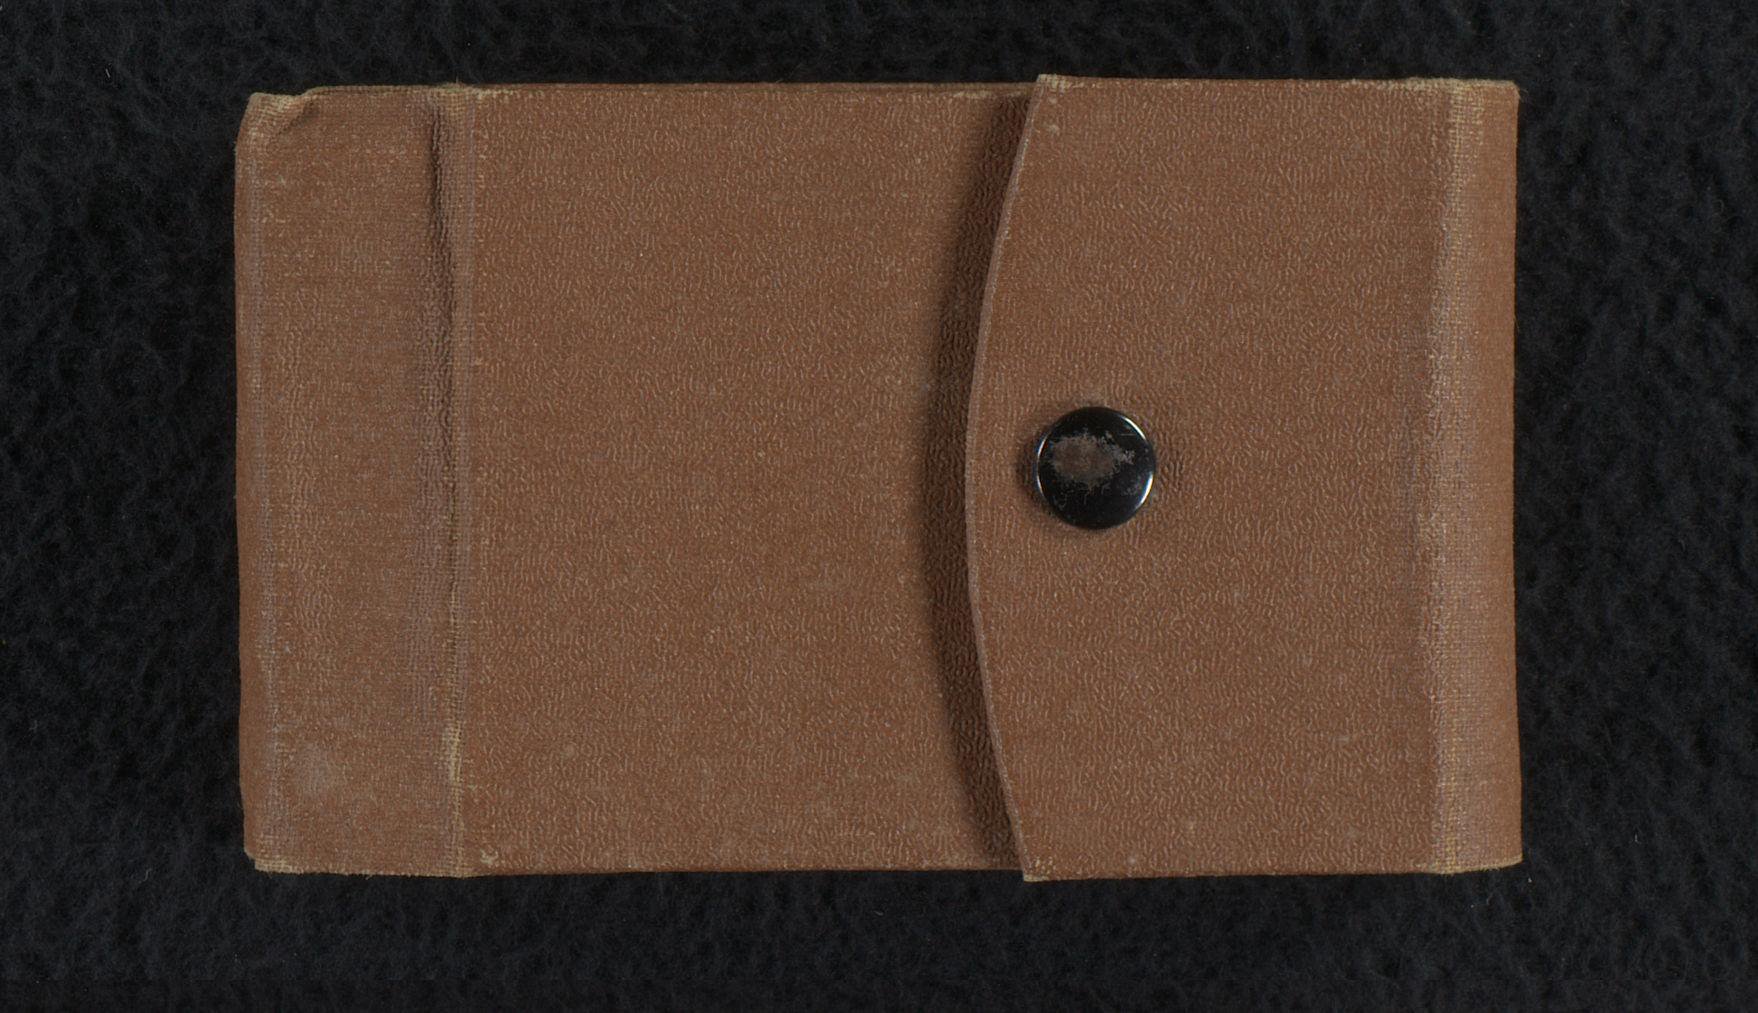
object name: filmnegatief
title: Album met honderd negatieven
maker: Anonymous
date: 1930-1931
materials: paper, cardboard, ink, metal, film, textile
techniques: gelatin silver negative, pen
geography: netherlands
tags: the family travelling, on holiday, historical persons not known by name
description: Negatiefalbum met honderd negatieven van een onbekende familie, onder andere in Nunspeet, Ermelo en Alkmaar. Bevat handgeschreven bijschriften achterin.